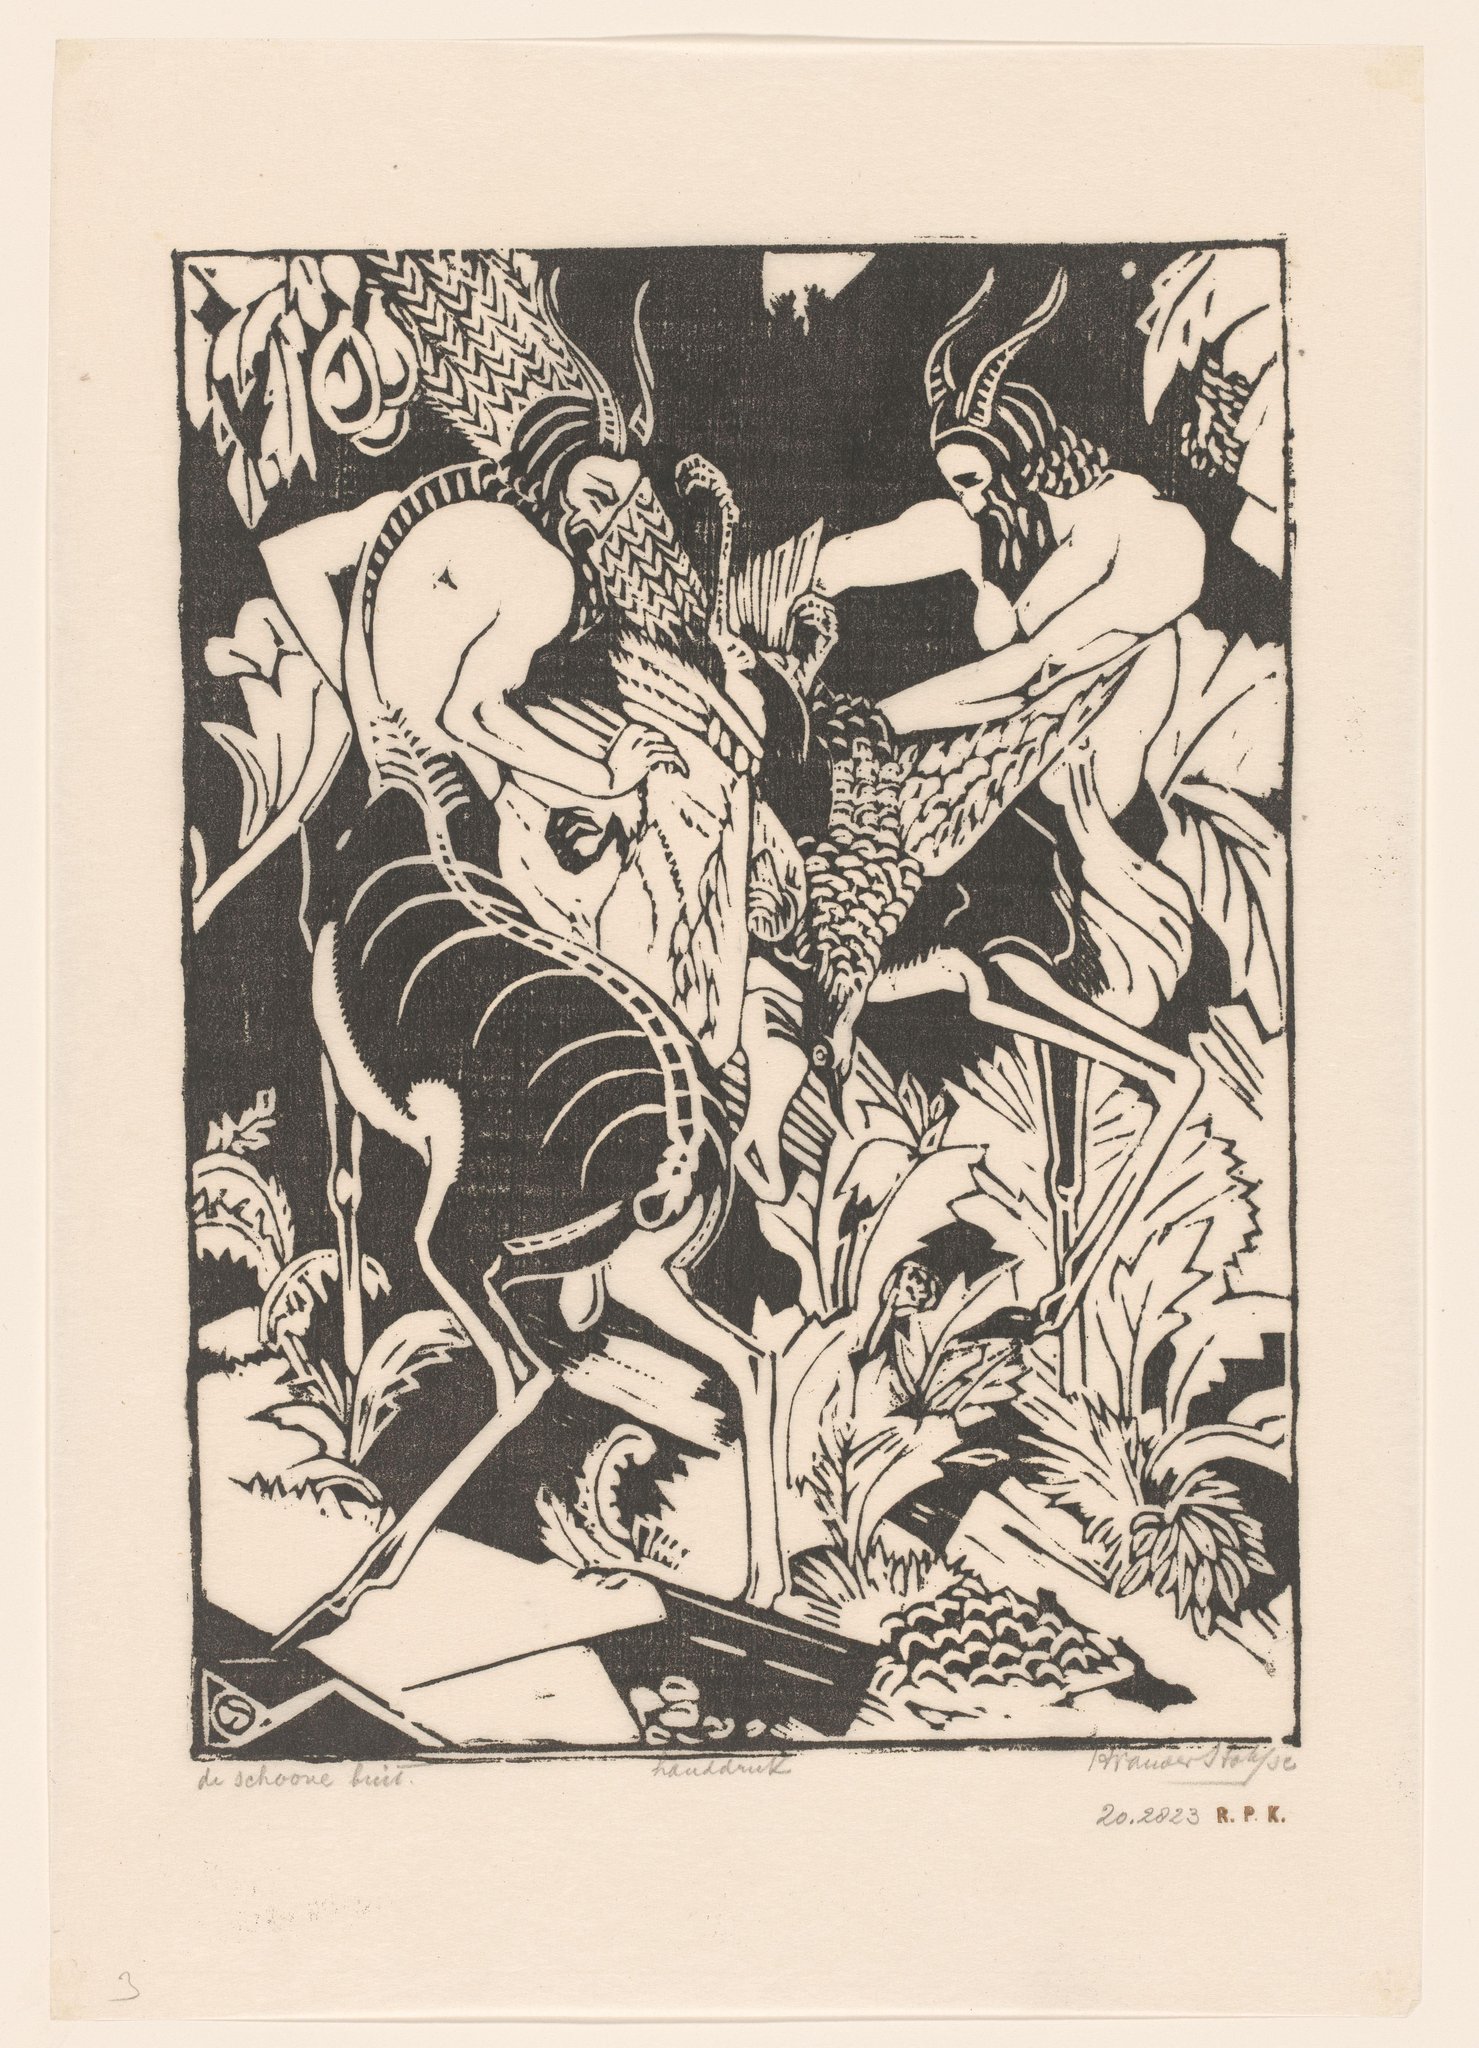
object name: print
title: De schoone buit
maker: henri van der stok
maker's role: print maker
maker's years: 1870-1946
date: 1880-1920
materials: paper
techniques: woodcut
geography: netherlands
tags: centaurs, bird hunting, ornamental birds: peacock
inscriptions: collector's mark: Lugt 2233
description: Twee centauren hebben een pauw gevangen.